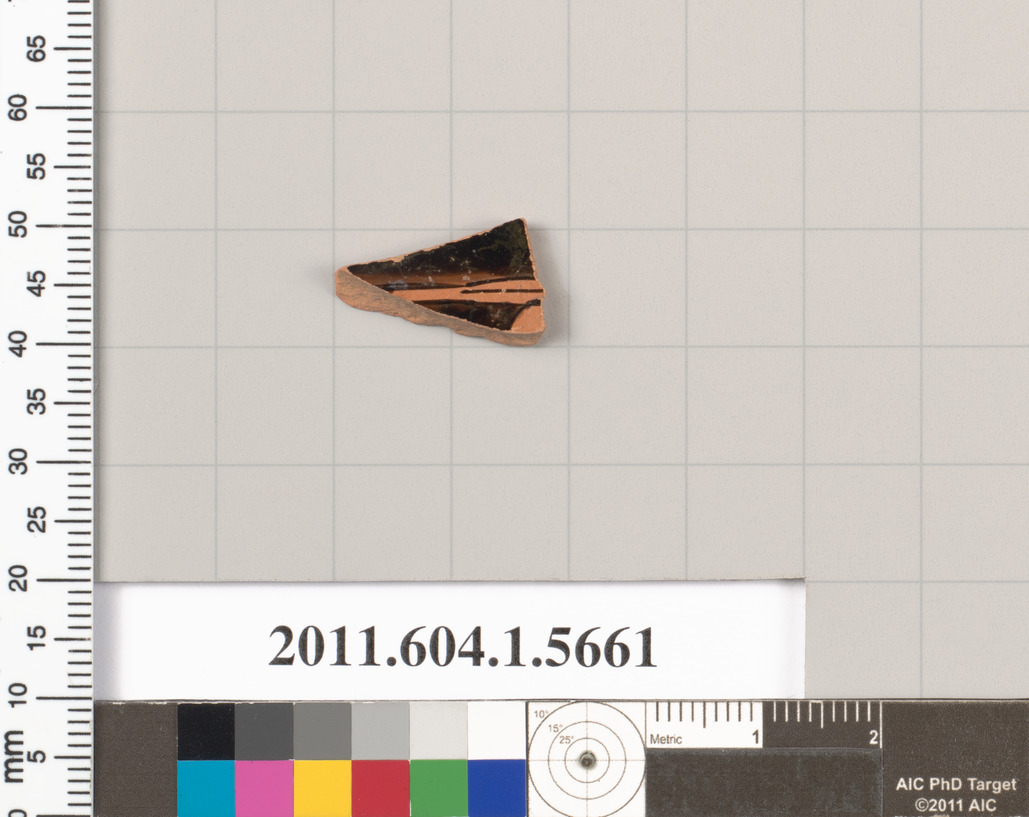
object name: kylix fragment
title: Terracotta fragment of a kylix (drinking cup)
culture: greek, attic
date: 500-480 BCE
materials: terracotta